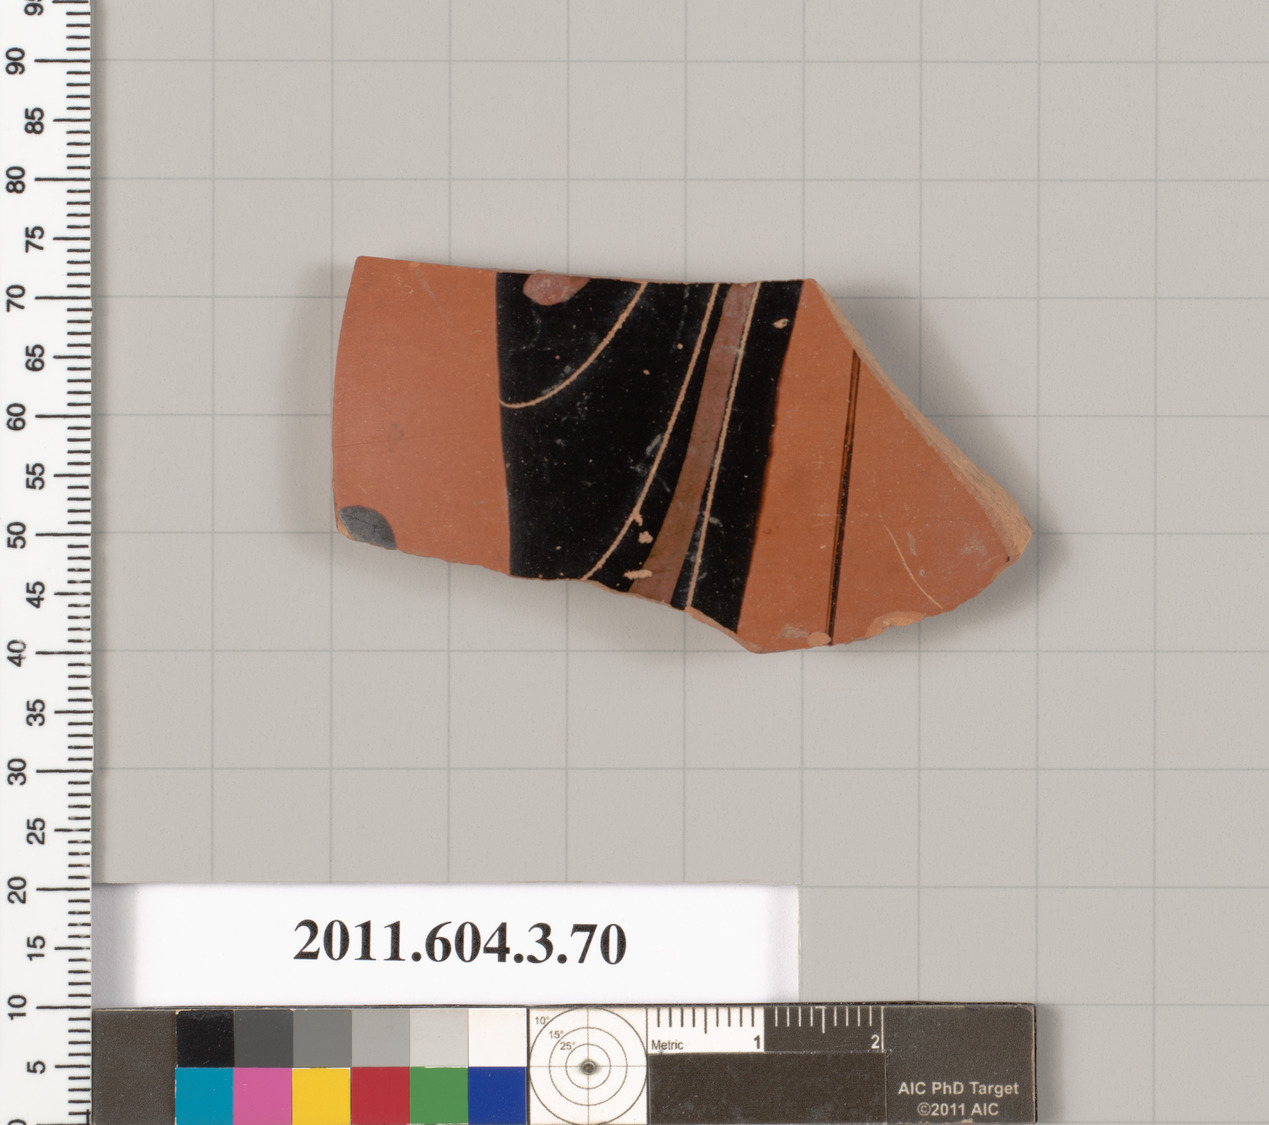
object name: amphora fragment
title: Terracotta fragment of an amphora (jar)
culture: greek, attic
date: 525-501 BCE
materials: terracotta